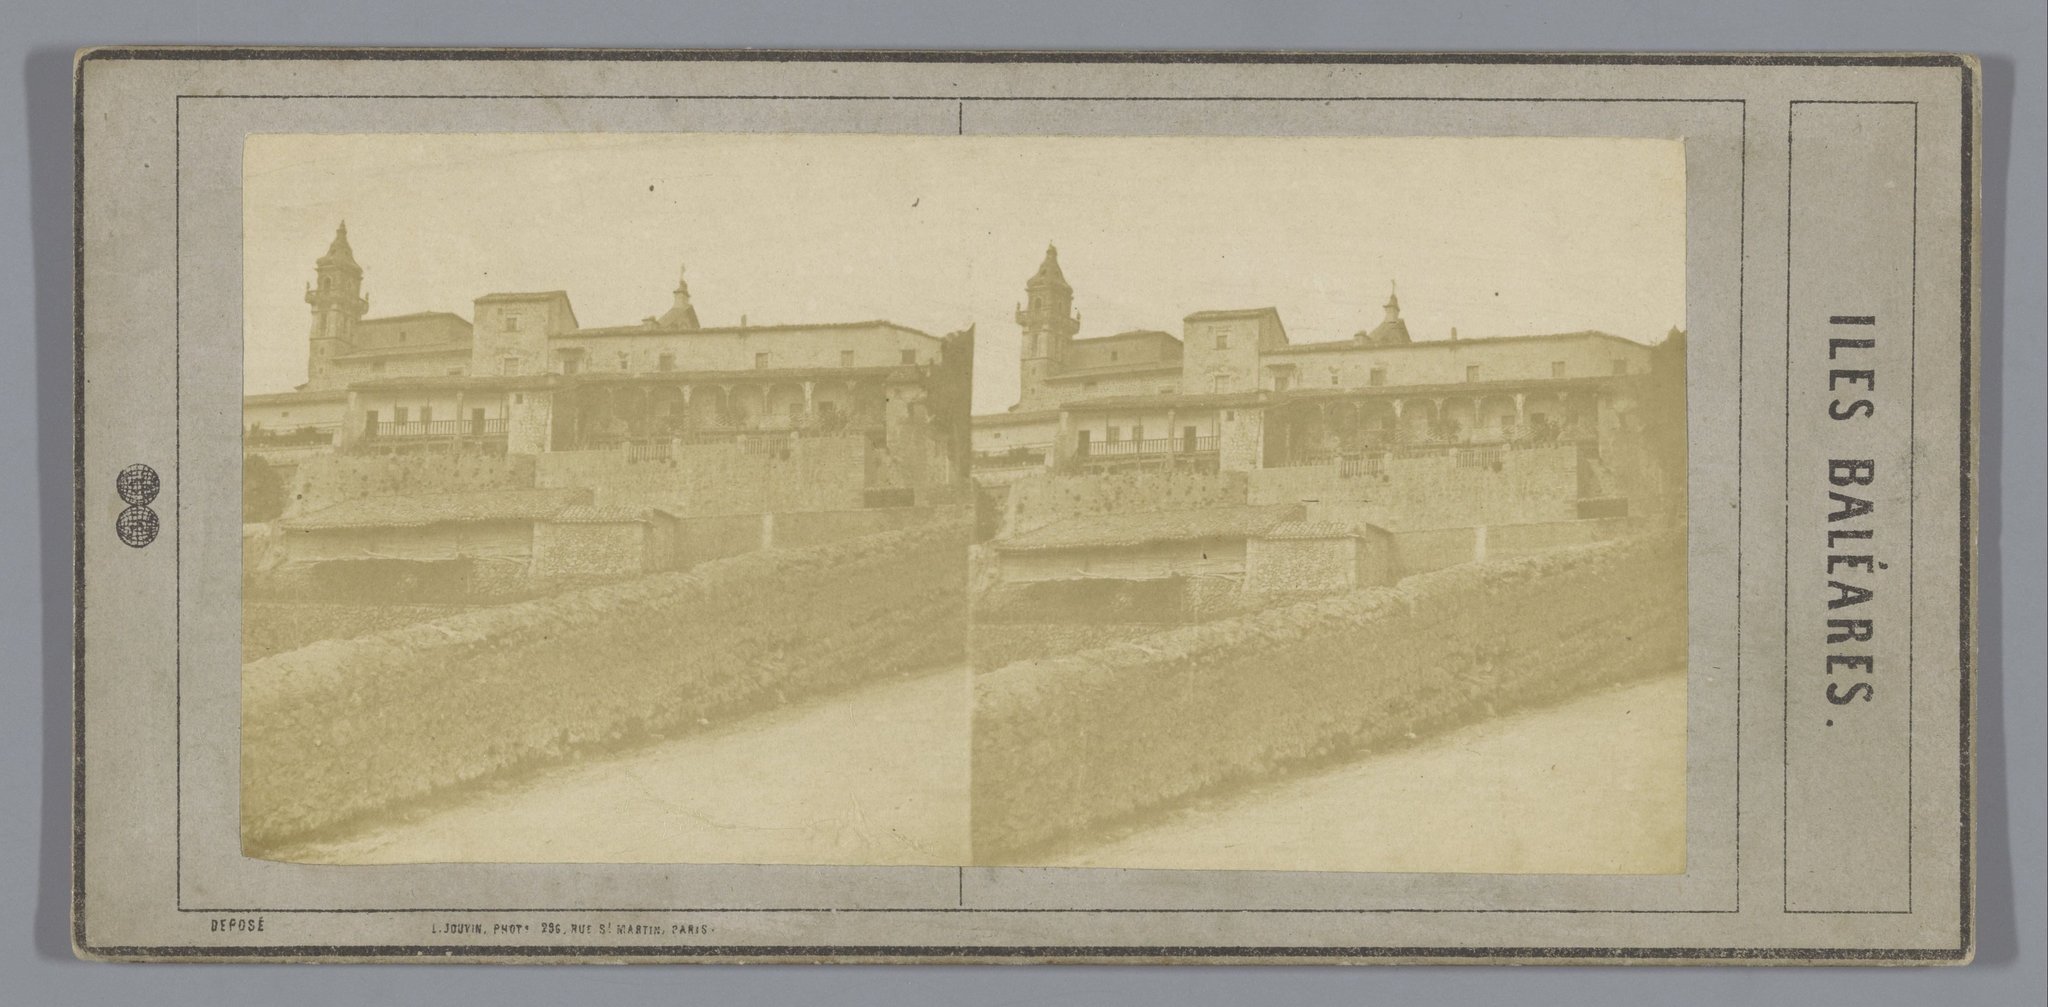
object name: photograph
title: Iles Baléares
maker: léon pierre jouvin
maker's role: fotograaf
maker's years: 1829-1891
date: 1858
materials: cardboard, photographic support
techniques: albumen print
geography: balearic islands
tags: city-view in general; 'veduta'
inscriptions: name: ‘L. Jouvin. Phot 296, Rue St Martin, Paris.’, number: ‘25’